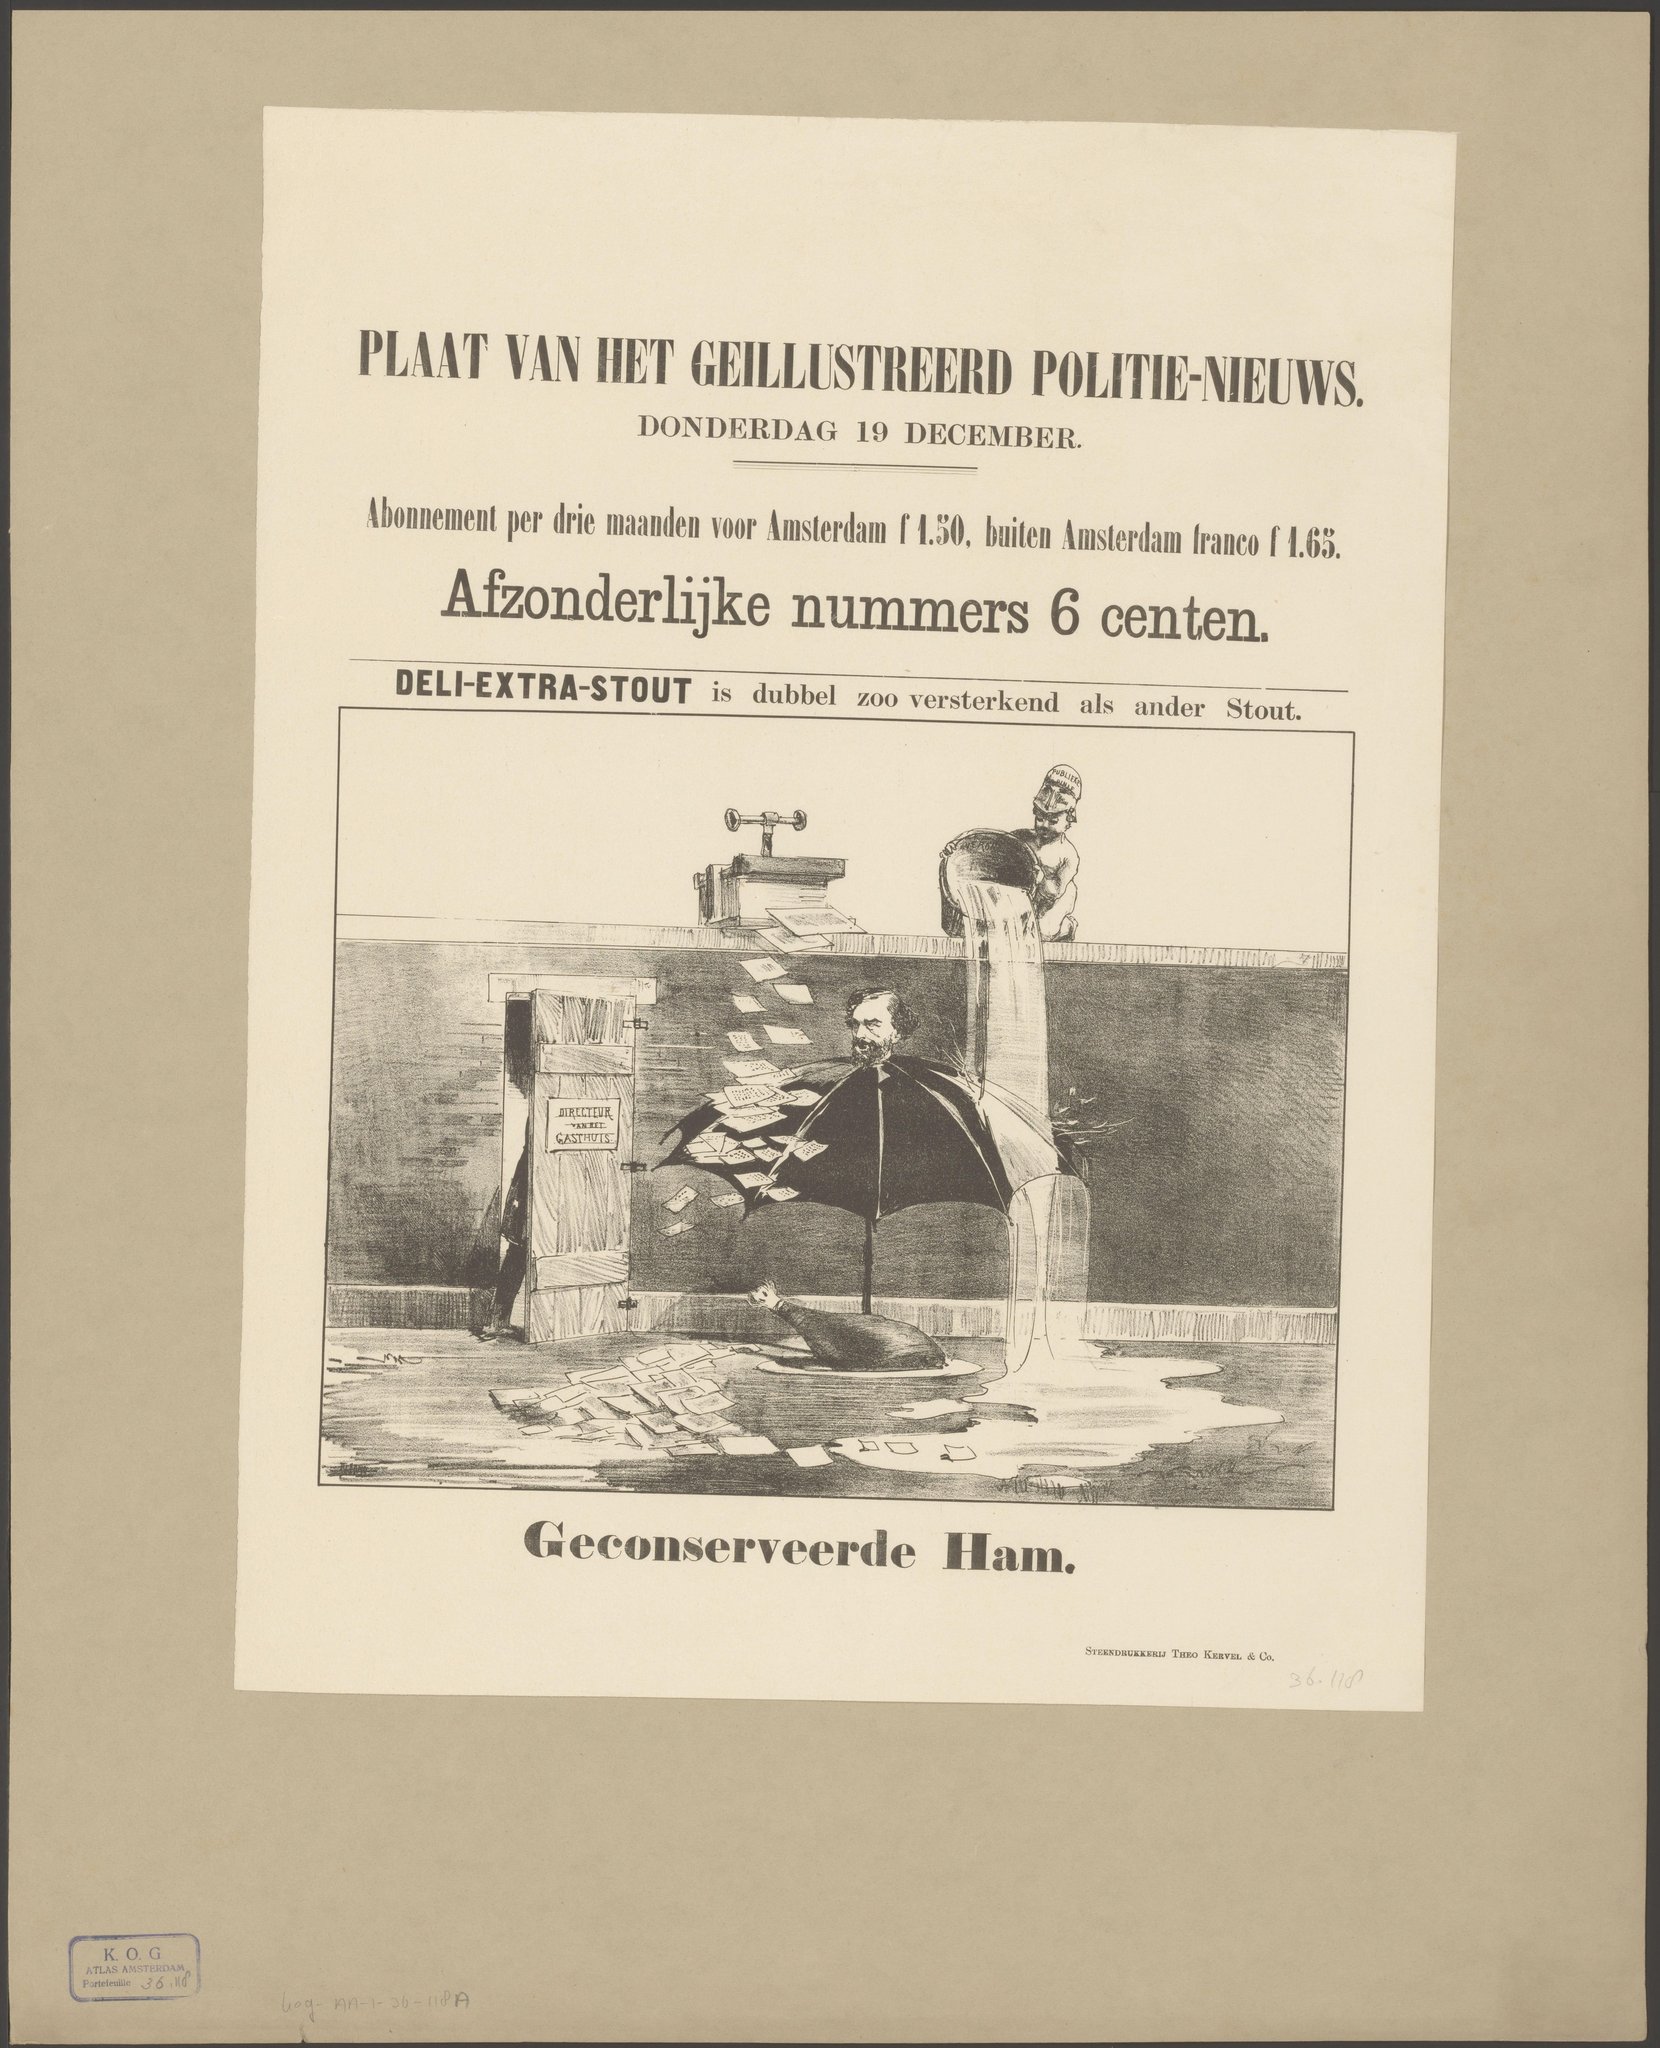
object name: print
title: Geconserveerde Ham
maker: Anonymous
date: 1880-1896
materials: paper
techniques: letterpress printing, lithograph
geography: amsterdam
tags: hospital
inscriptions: collector's mark: Lugt 1641b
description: Publieke opinie gooit een emmer vloeistof in een leeg zwembad. In het zwembad ligt een ham met daarboven een paraplu met het hoofd van de directeur van het gasthuis. Onderwerpsrubriek binnen de Atlas Amsterdam: Armwezen en liefdadige instellingen: I. Stadsinrichtingen: Binnengasthuis.